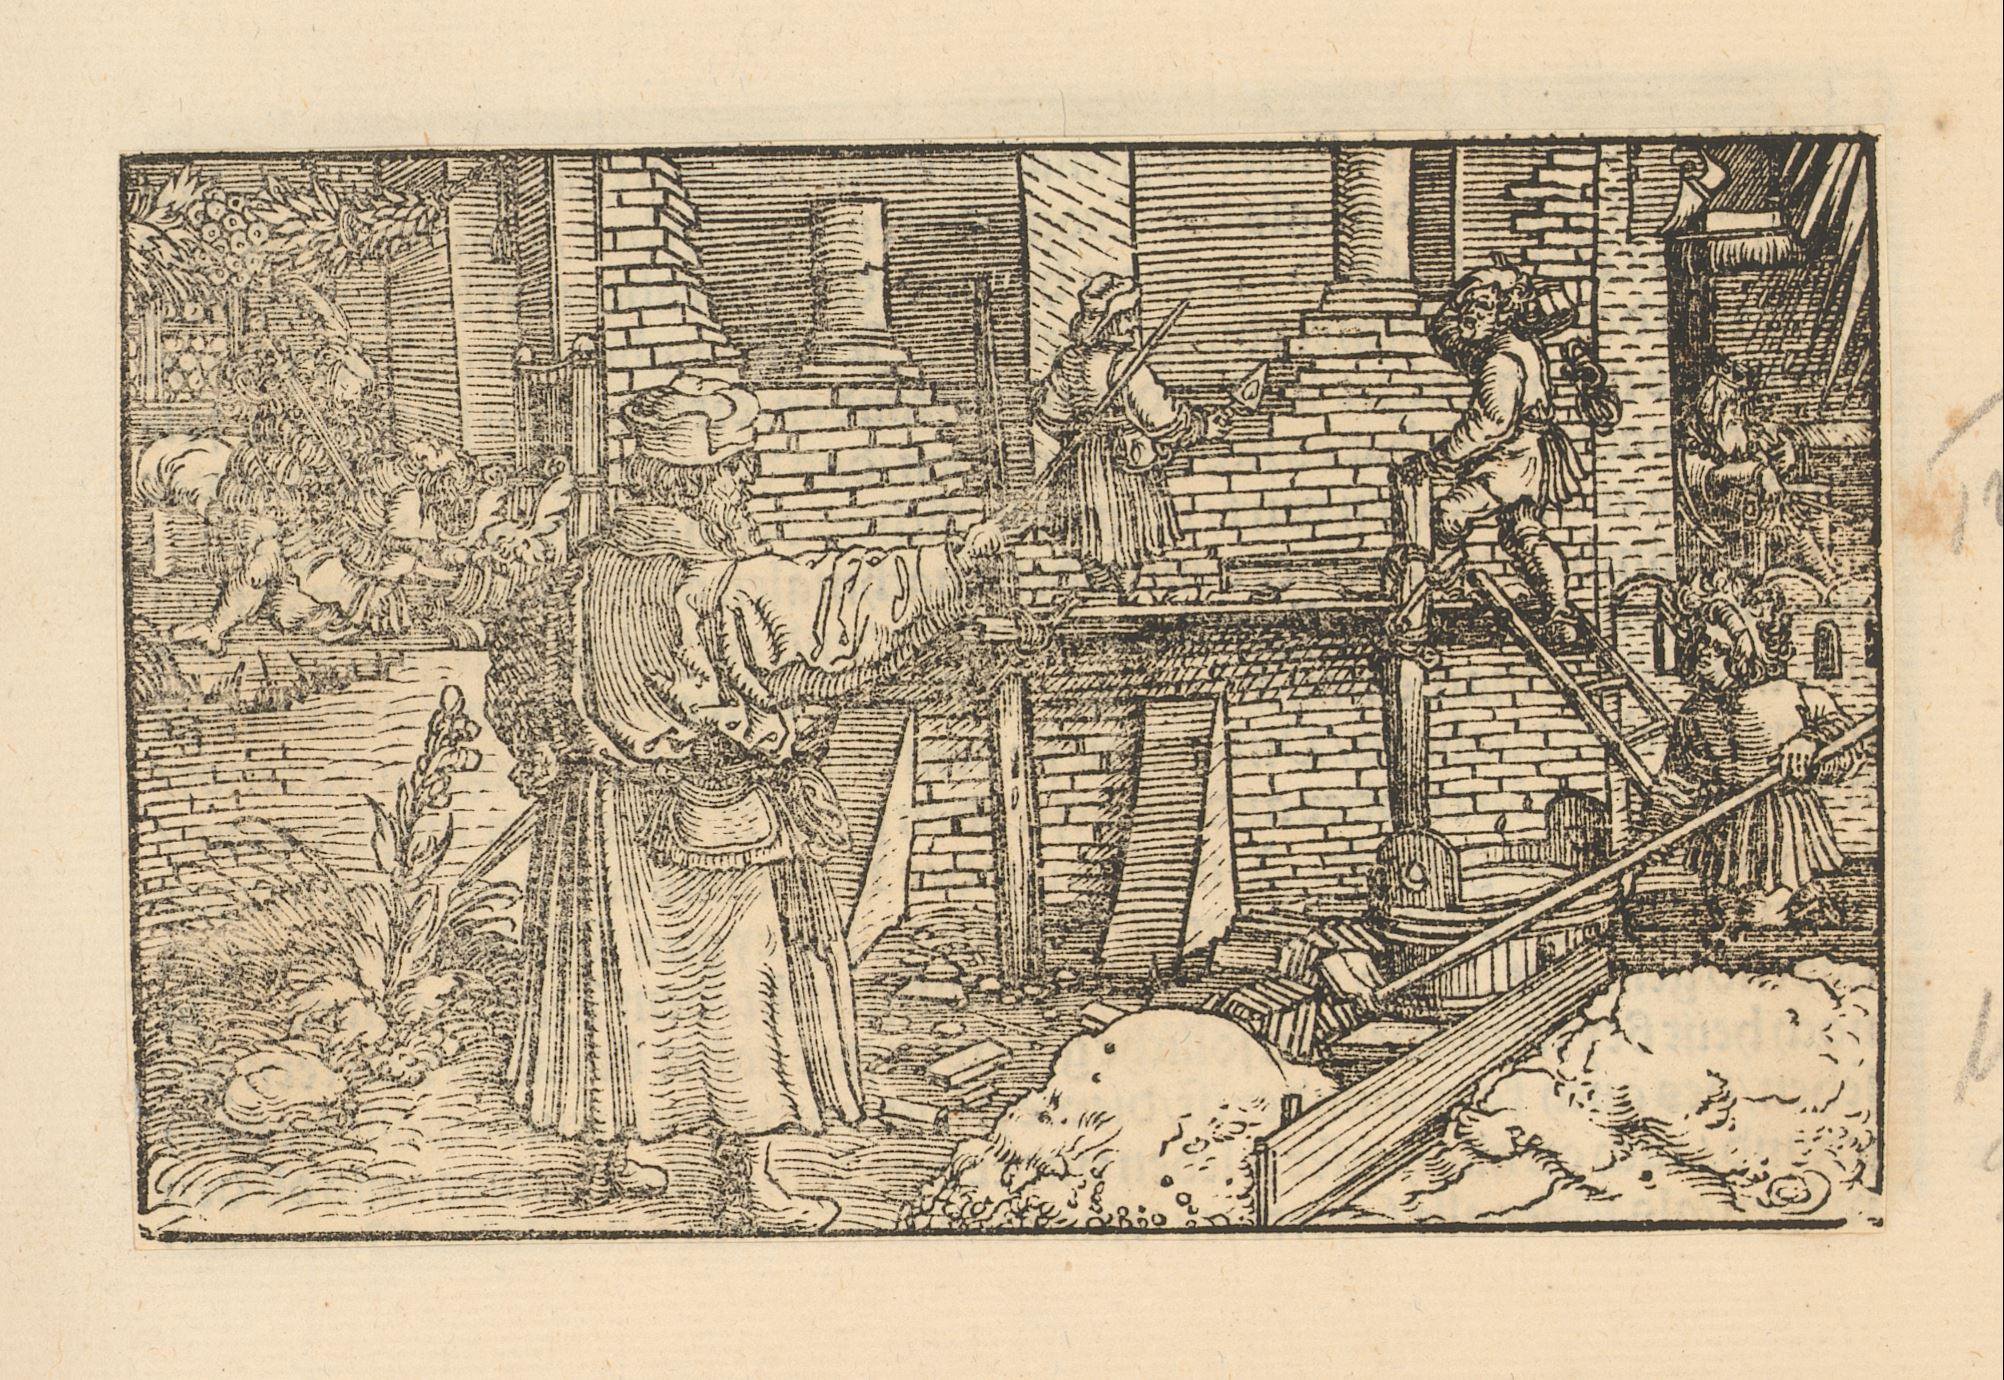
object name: print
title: Bouwplaats met bouwmeester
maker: Anonymous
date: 1514-1532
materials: paper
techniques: letterpress printing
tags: murder, building-site, architect supervising building activities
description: Deze prent is gebruikt in: Petrarca, Francesco. Von der Artzney bayder Glück, des guten und widerwertigen: unnd weß sich ain yeder inn Gelück und Unglück halten sol (...). Augsburg: Heinrich Steiner, 1532. Deze uitgave is ook bekend onder de titel 'Trostspiegel in Glück und Unglück'.